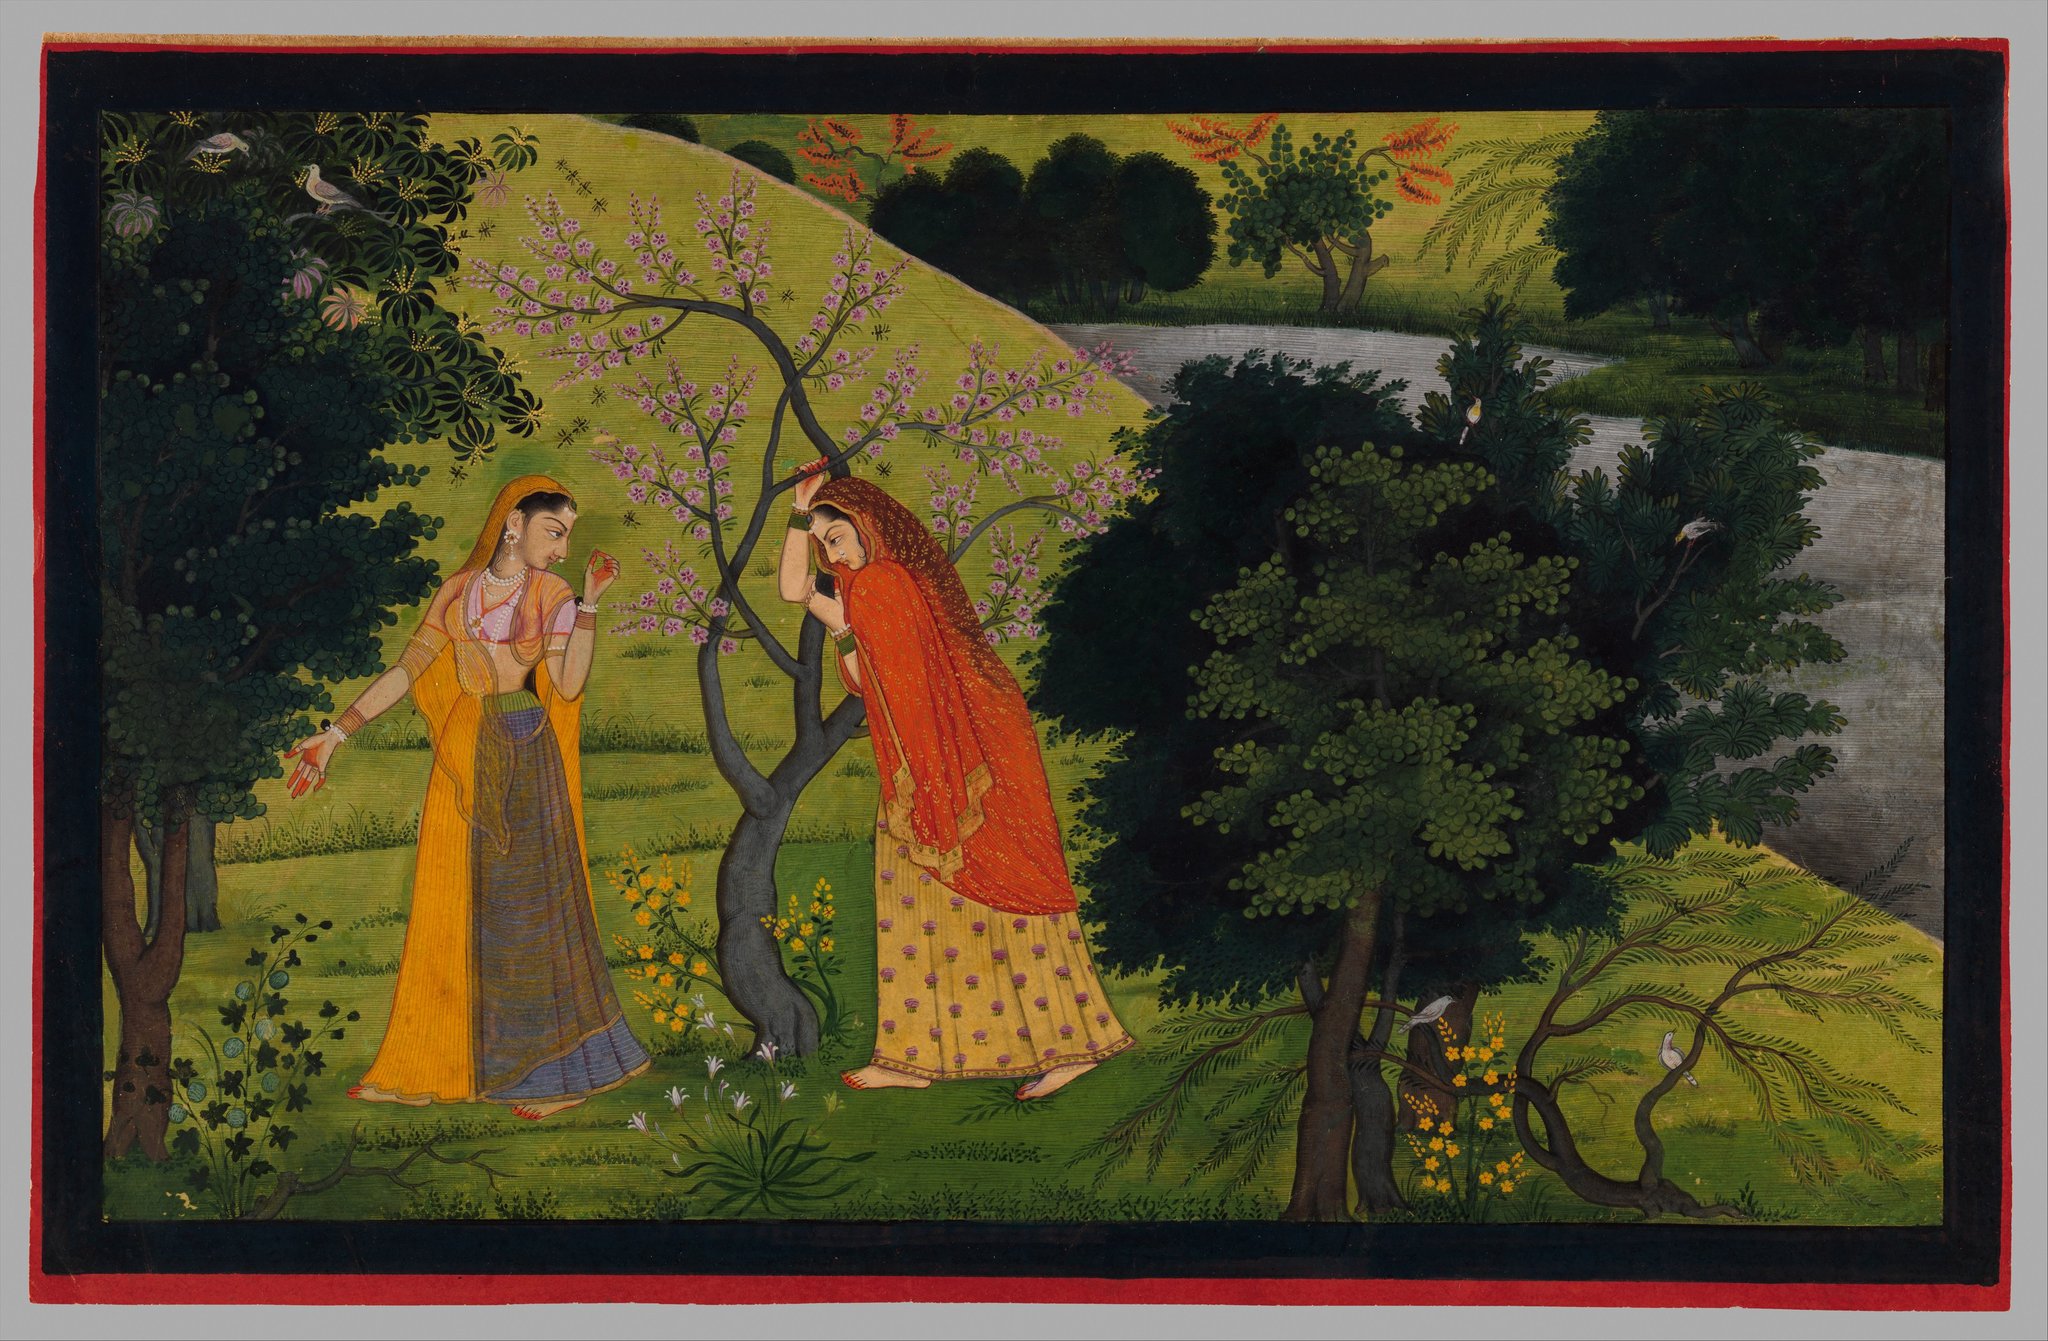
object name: folio from an illustrated manuscript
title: "Radha with Her Confidant, Pining for Krishna", Folio from the "Second" or "Tehri Garhwal" Gita Govinda (Song of the Cowherd)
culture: indian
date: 1775-1780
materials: gold, paper, watercolor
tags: women,landscapes,radha